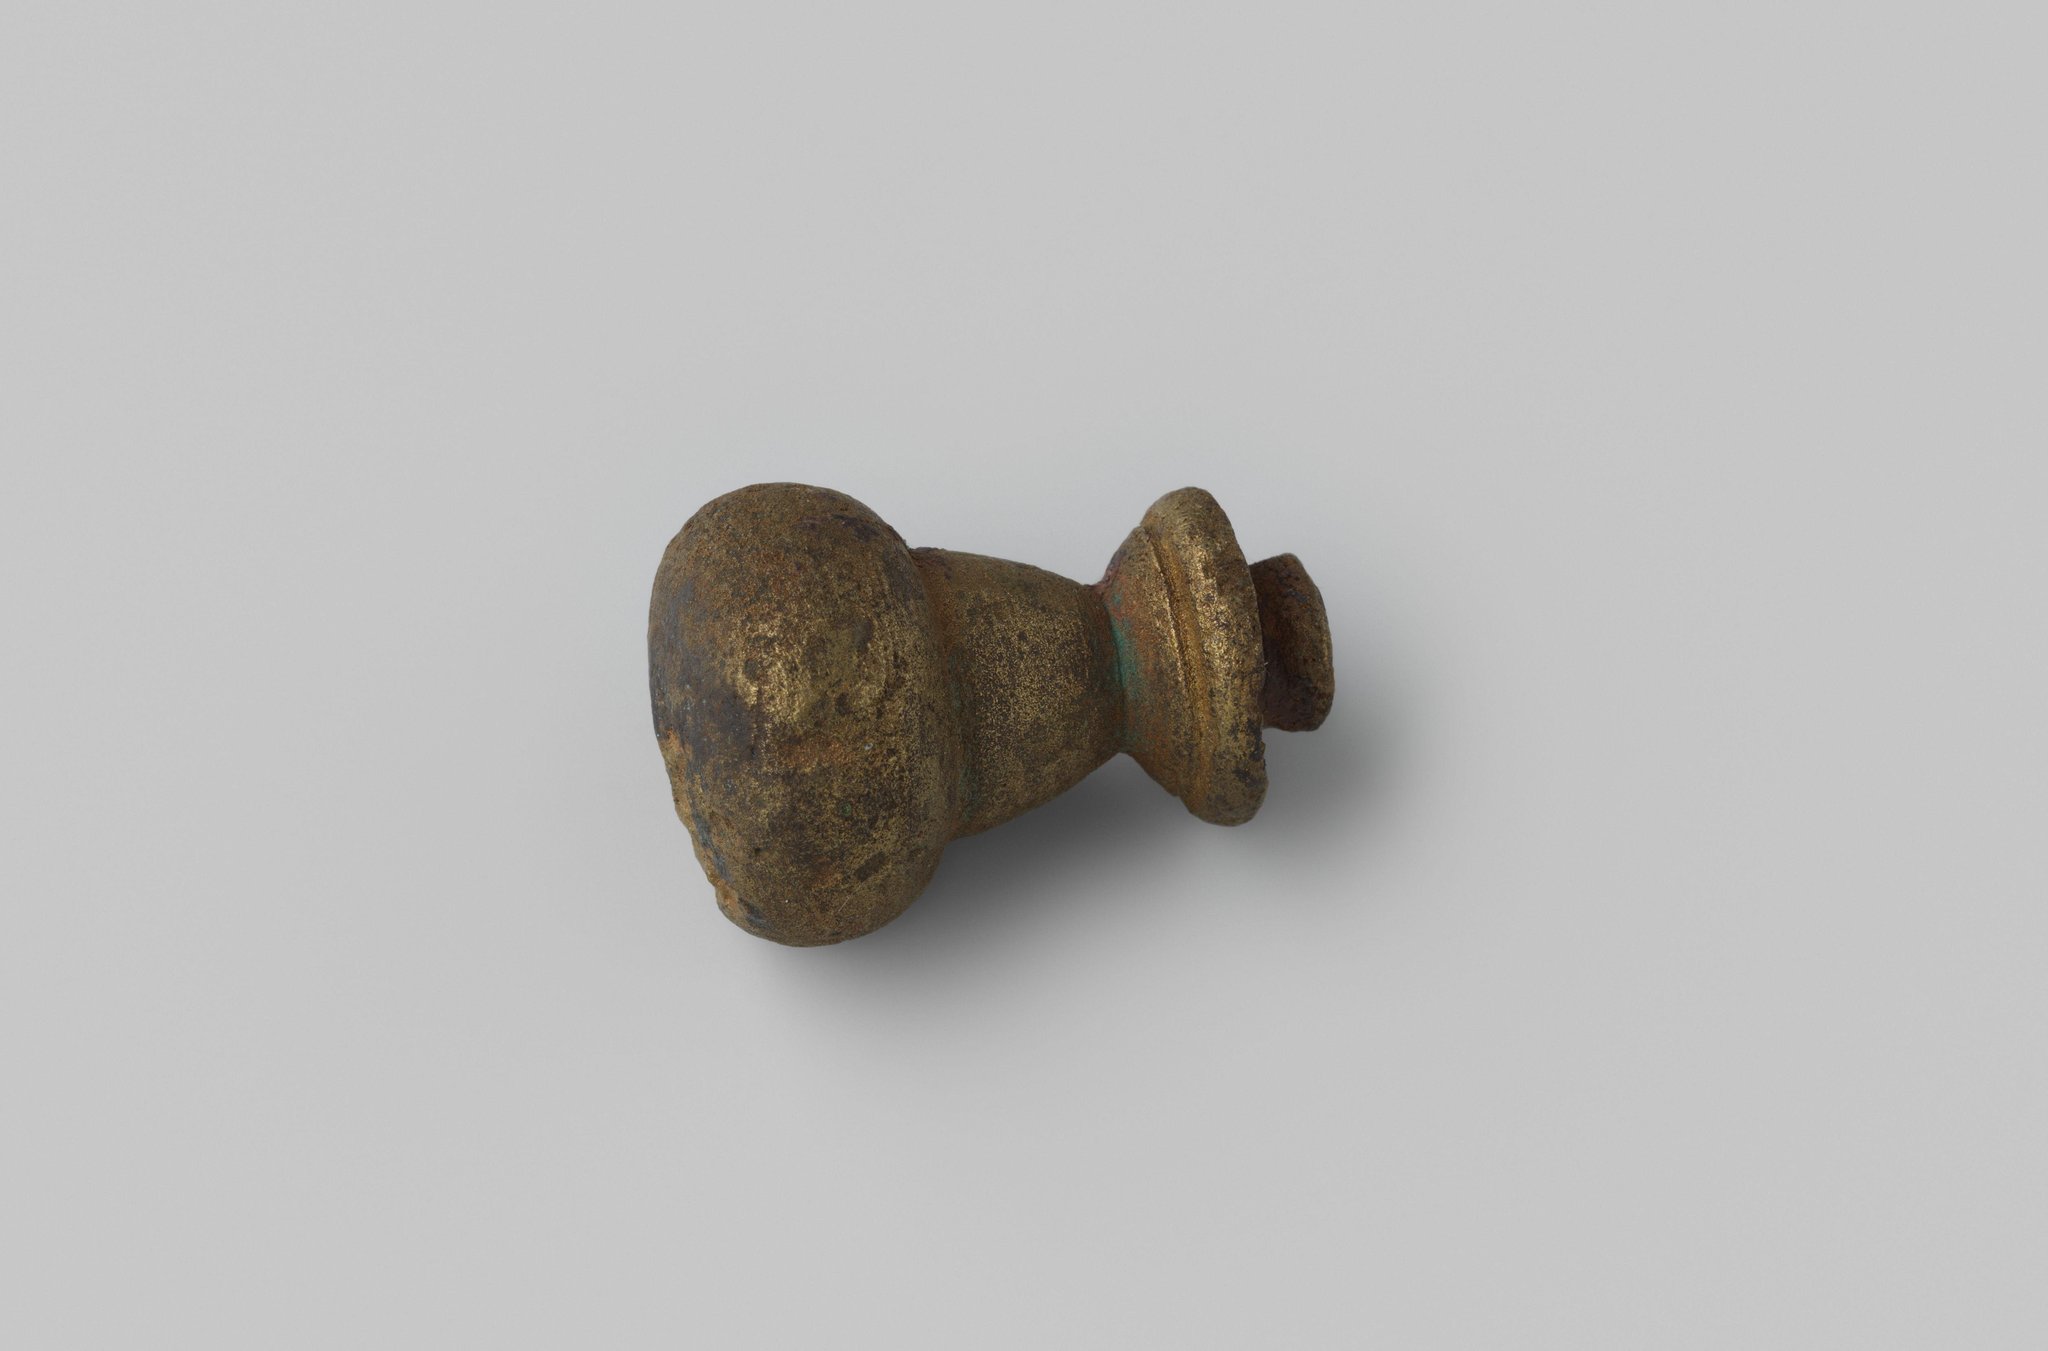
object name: knob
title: Knop uit het wrak van de Oost-Indiëvaarder Hollandia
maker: Anonymous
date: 1700-1743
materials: copper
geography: netherlands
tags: verenigde oostindische compagnie, hollandia (schip), annet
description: Fitting, knob; acron-shaped, stepped base, tenon projecting.